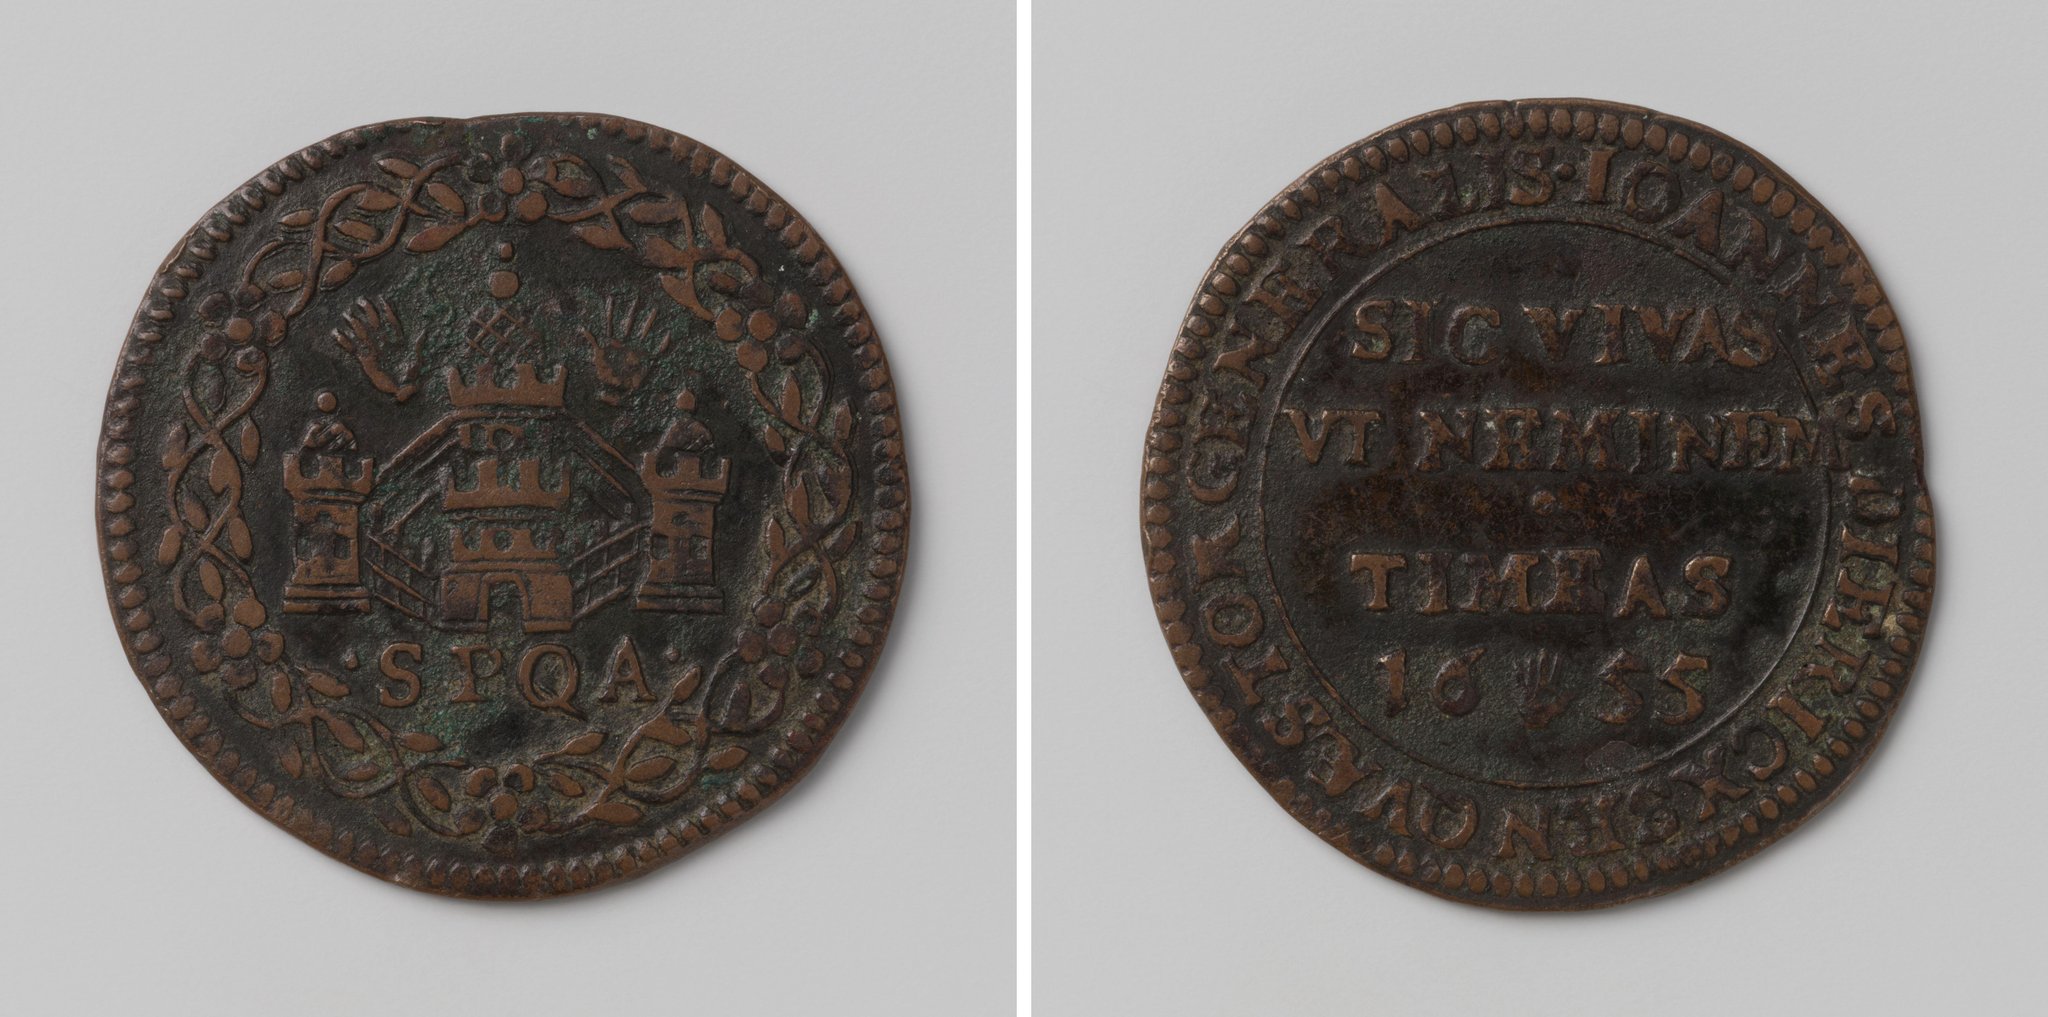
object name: jeton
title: Johannes Diericxsen, rentmeester-generaal van de stad Antwerpen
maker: Anonymous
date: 1655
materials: copper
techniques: striking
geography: antwerp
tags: antwerp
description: Koperen penning. Voorzijde: burcht van Antwerpen onder twee geopende handpalmen boven opschrift binnen krans van bladeren en bloemen. Keerzijde: opschrift binnen omschrift